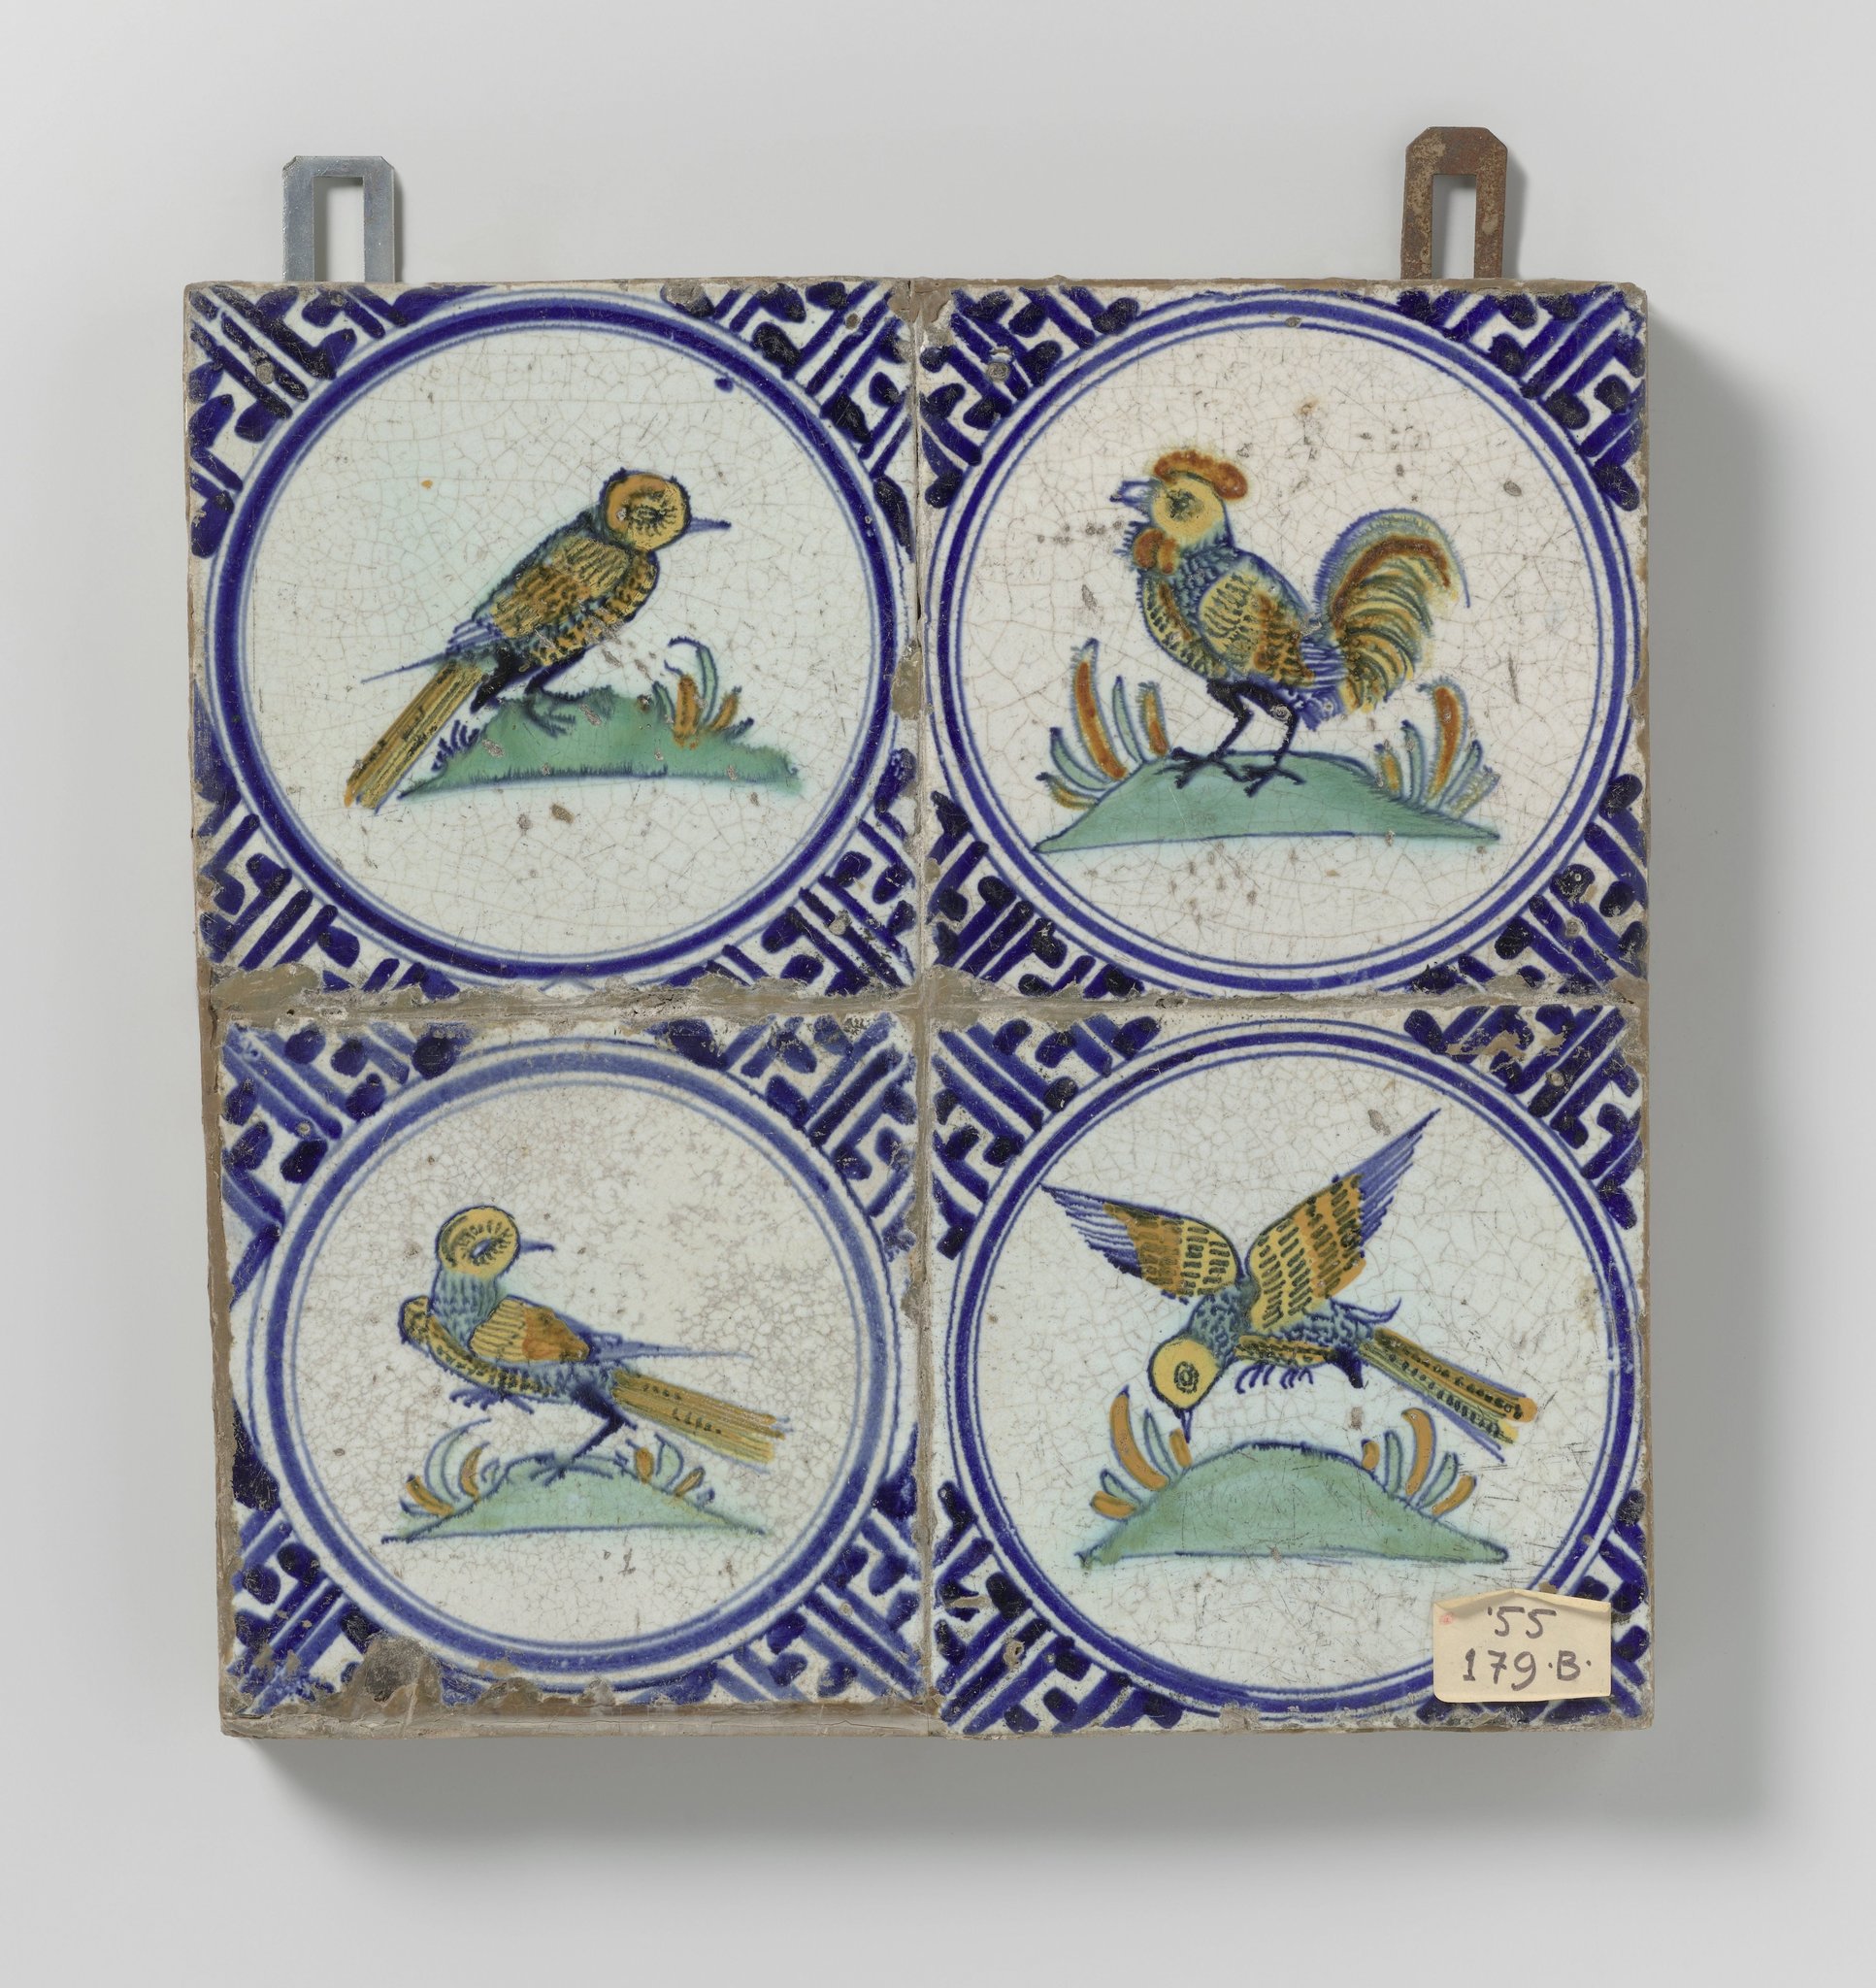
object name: tile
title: Veld van vier tegels met vogels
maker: Anonymous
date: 1620-1640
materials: earthenware, glaze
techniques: maiolica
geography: netherlands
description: Veld van vier tegels (2 x 2) elk met een veelkleurige (blauw, oranje, groen, geel en paars) vogel binnen een cirkel op een grondje. In de hoeken, meanderornament.